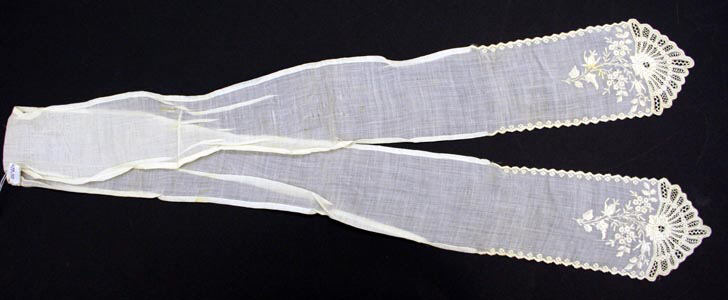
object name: necktie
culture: american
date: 1867-1900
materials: cotton